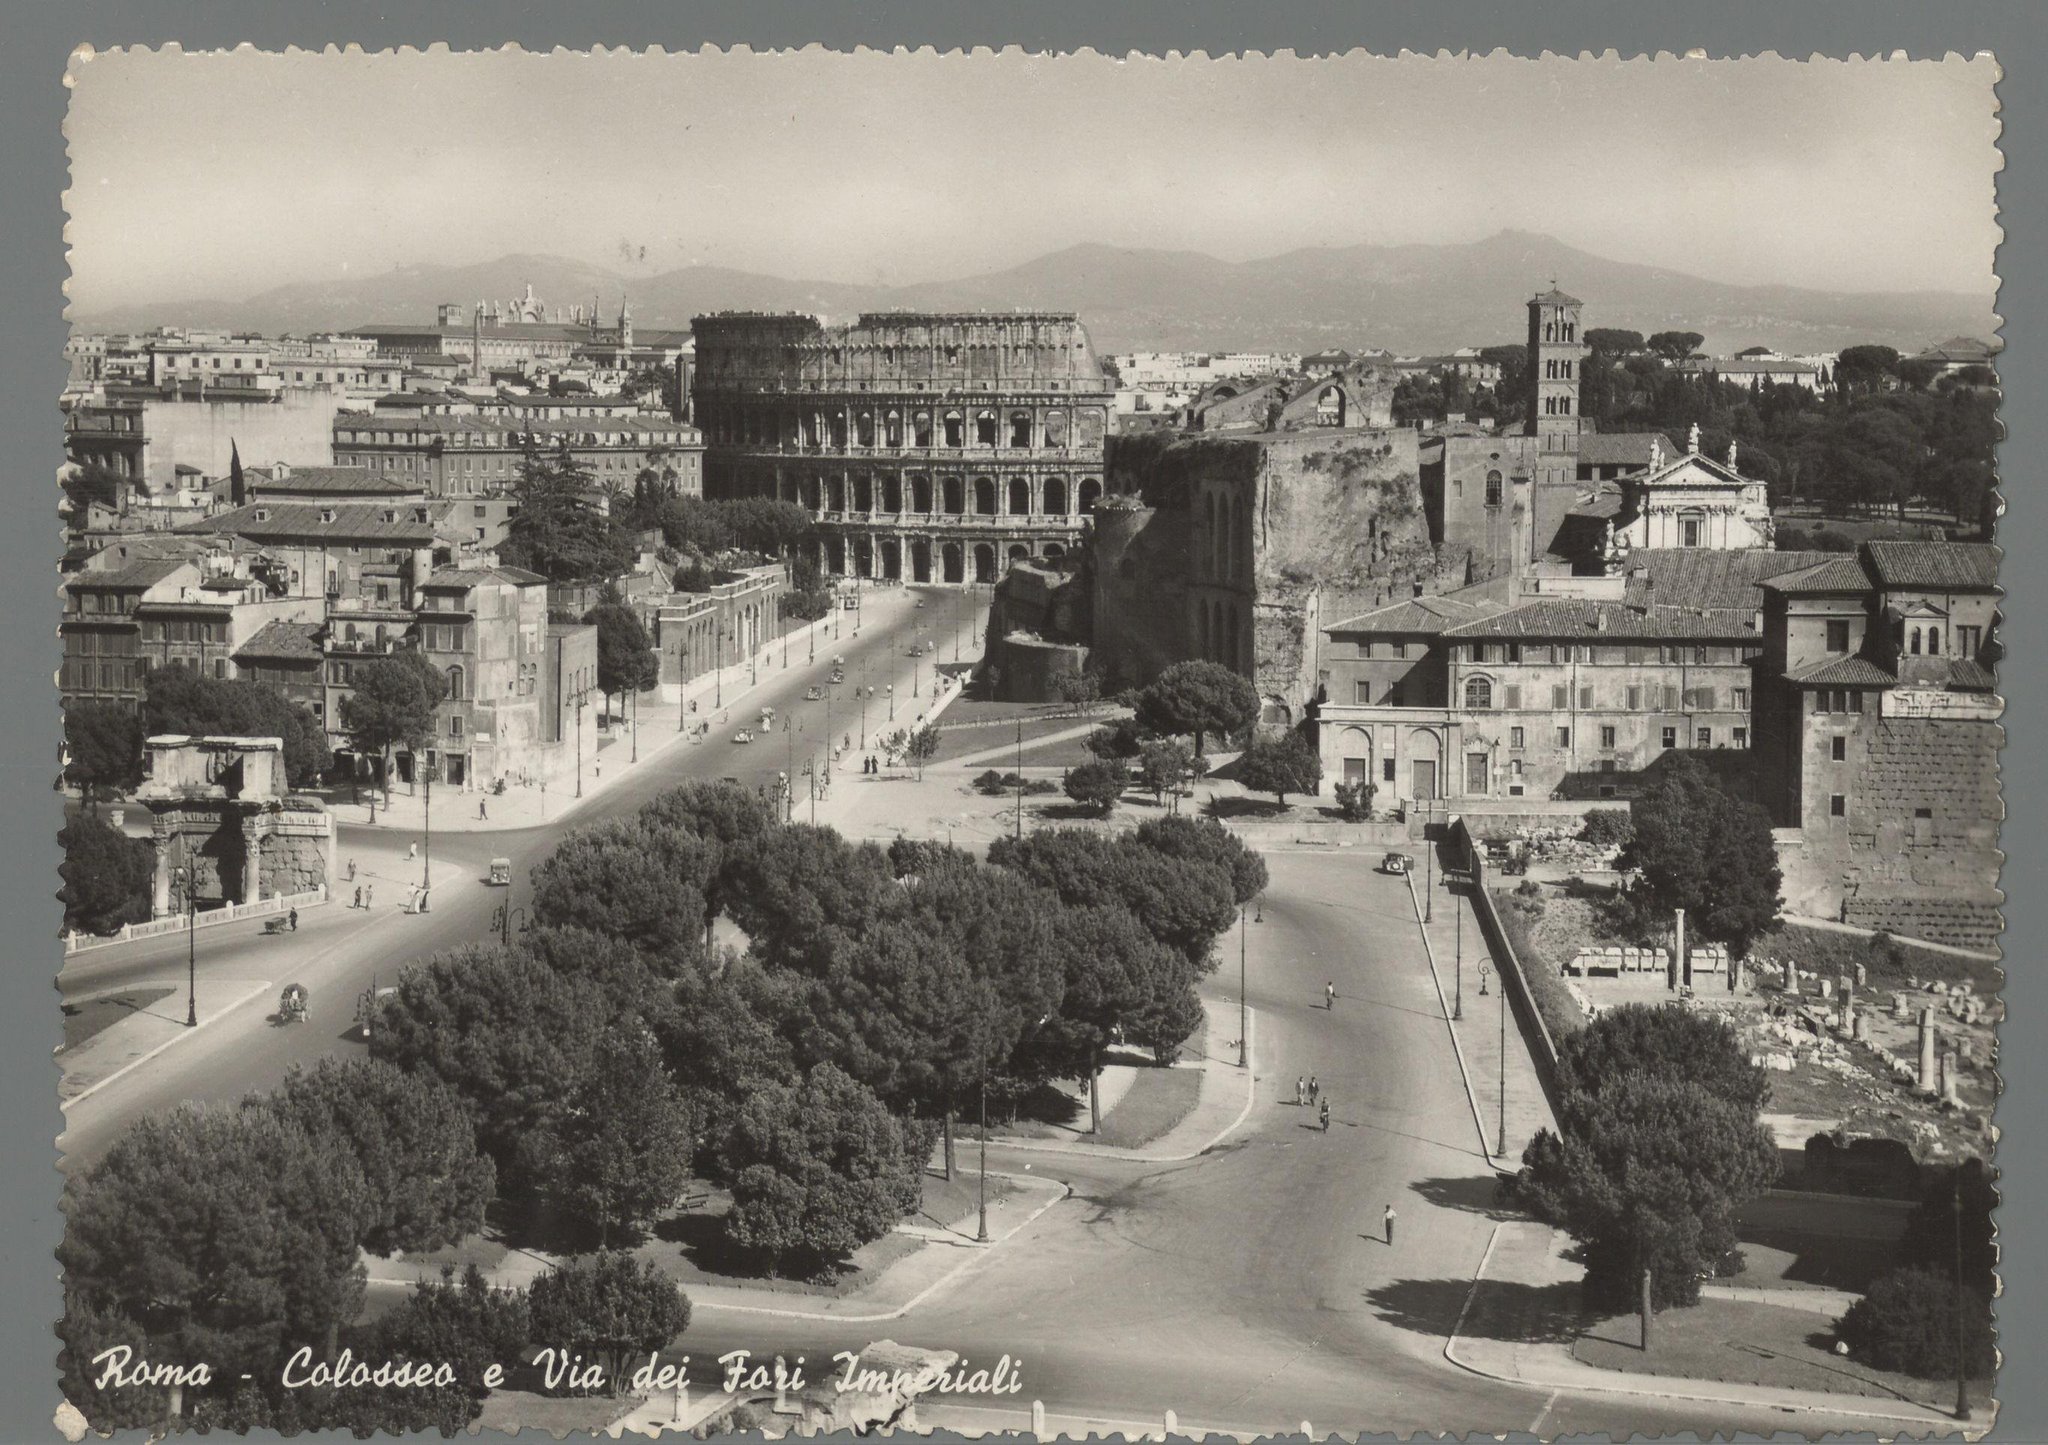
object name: ansichtkaart, prentbriefkaart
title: Roma. Colosseo e Via dei Fori Imperiali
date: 1950-1951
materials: photographic support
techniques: photography, writing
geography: turin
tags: ruin of a building ~ architecture, avenue, boulevard, promenade, esplanade (+ city(-scape) with figures, staffage), city-view, and landscape with man-made constructions (+ city(-scape) with figures, staffage), rome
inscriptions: postage stamp